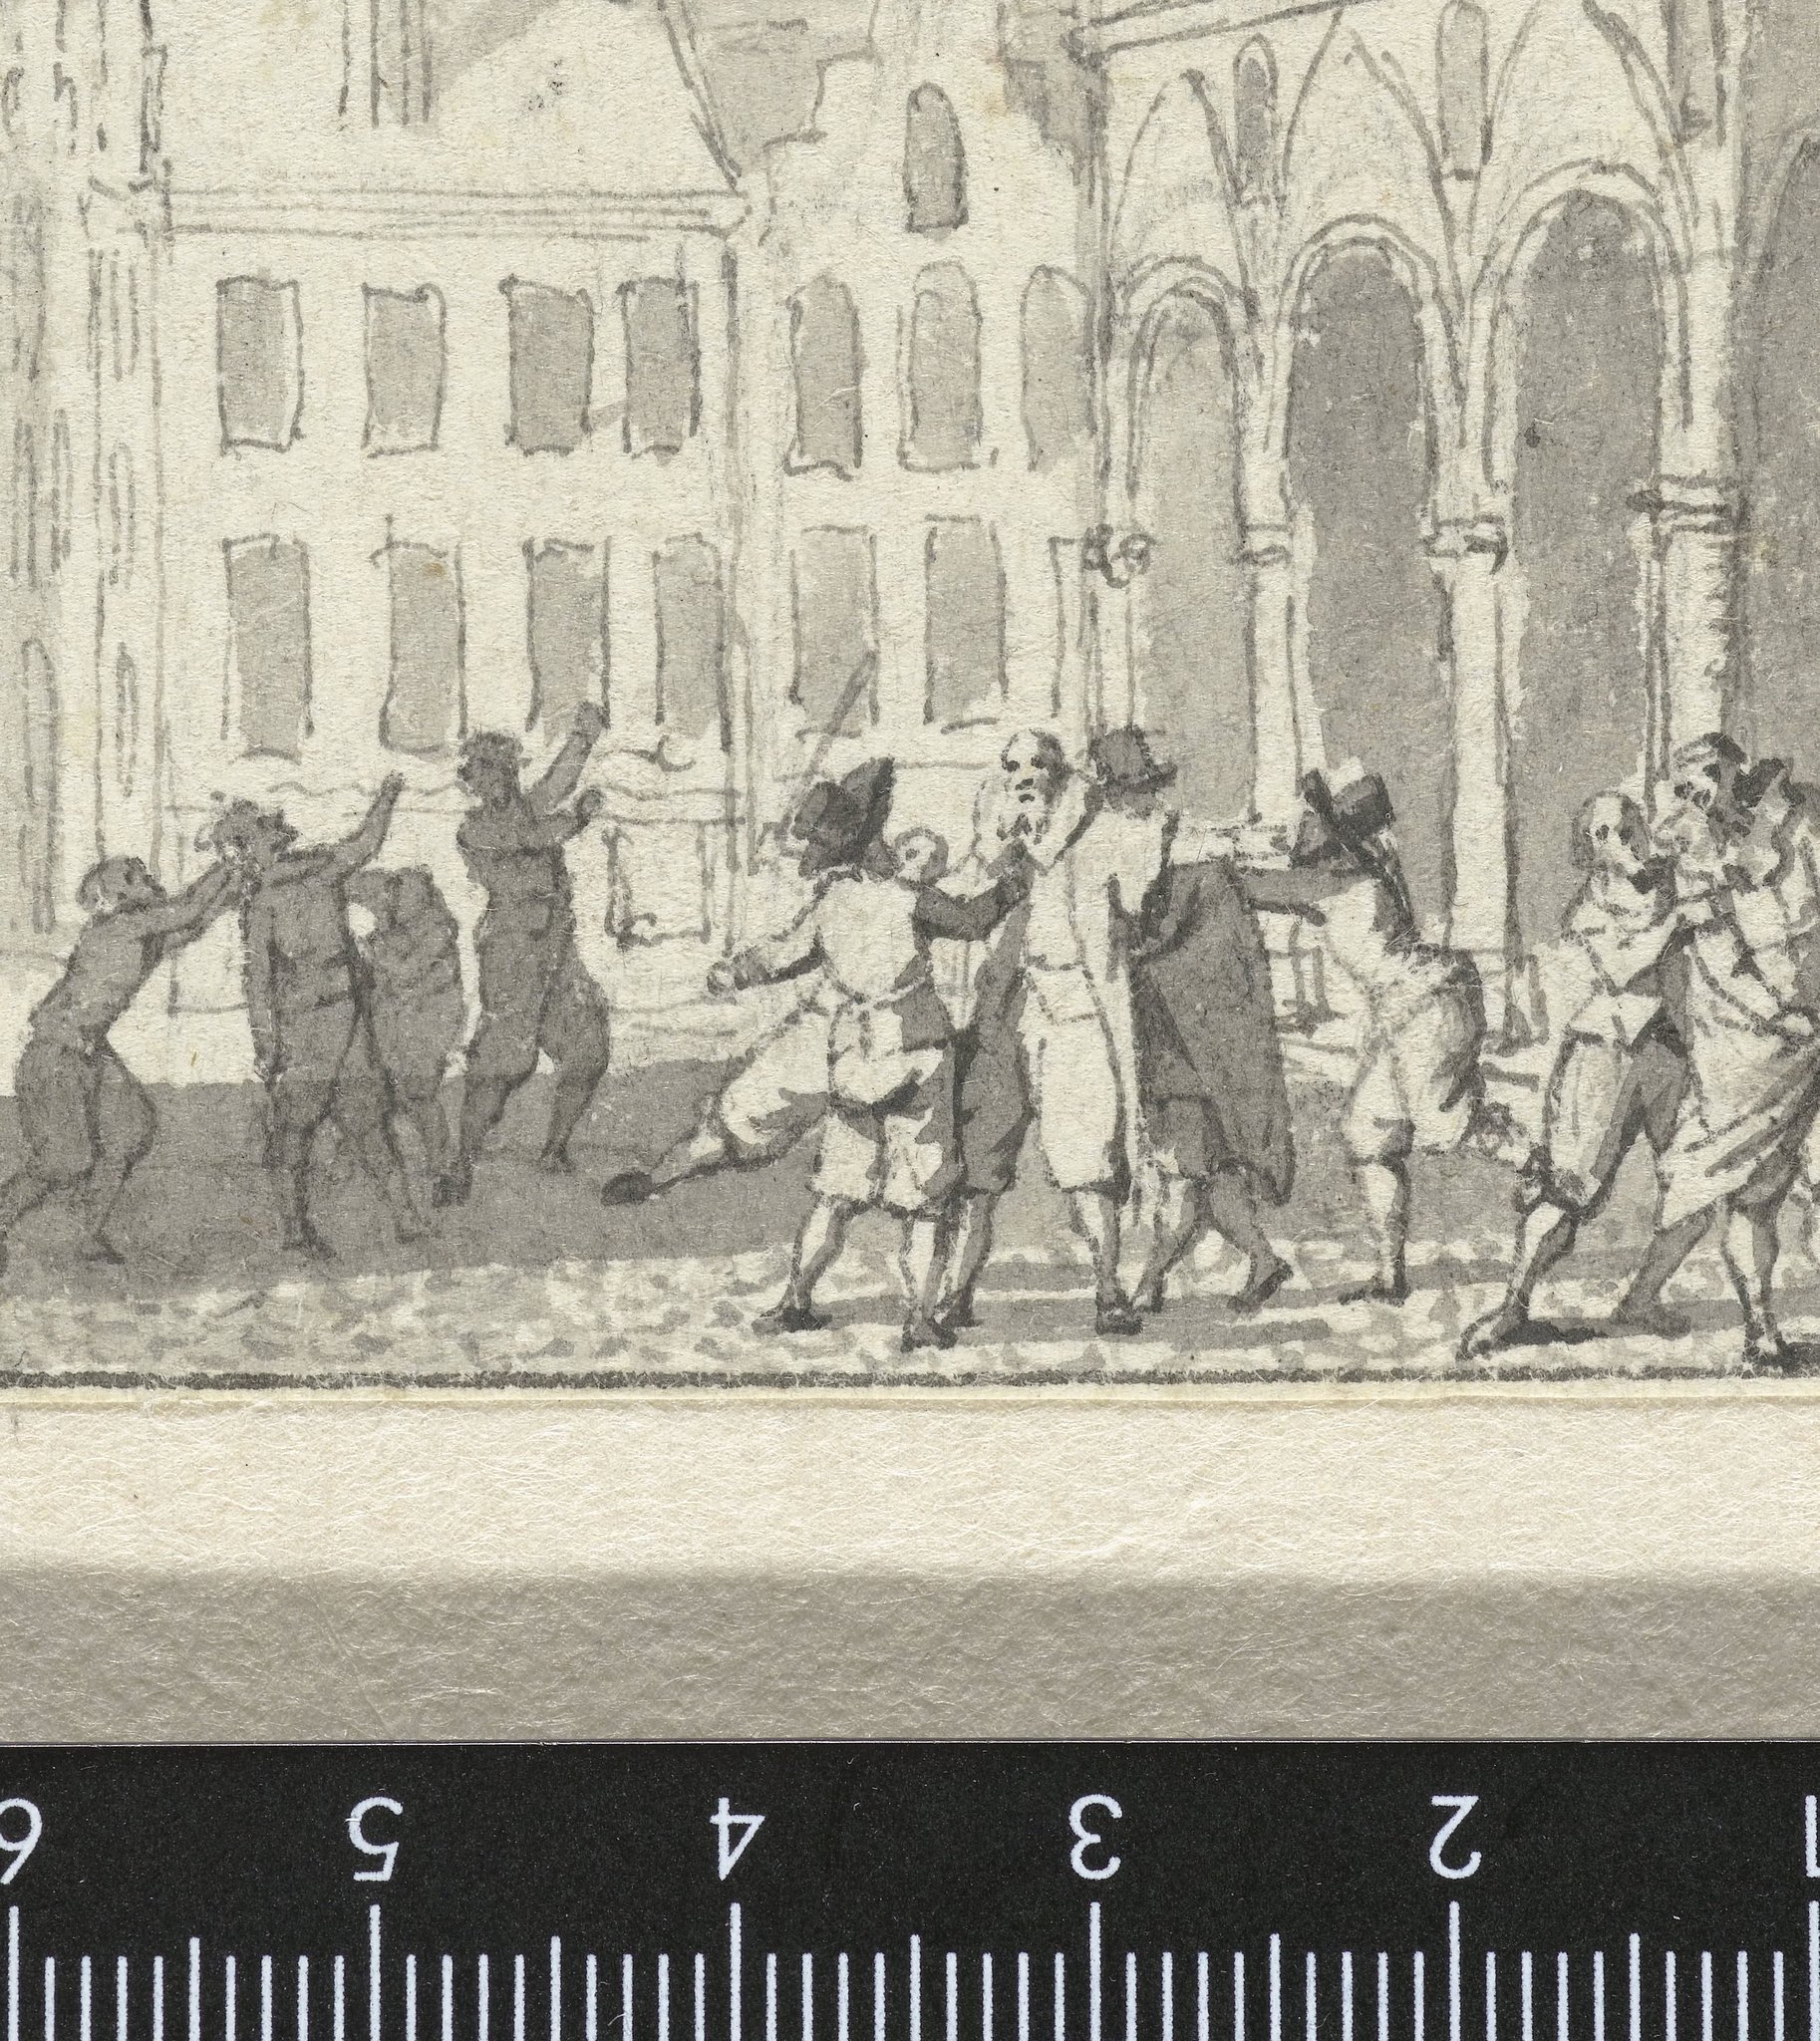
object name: design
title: In 't Jaar 1578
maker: Anonymous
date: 1700-1800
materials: ink, paper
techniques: brush, pen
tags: street, historical events and situations